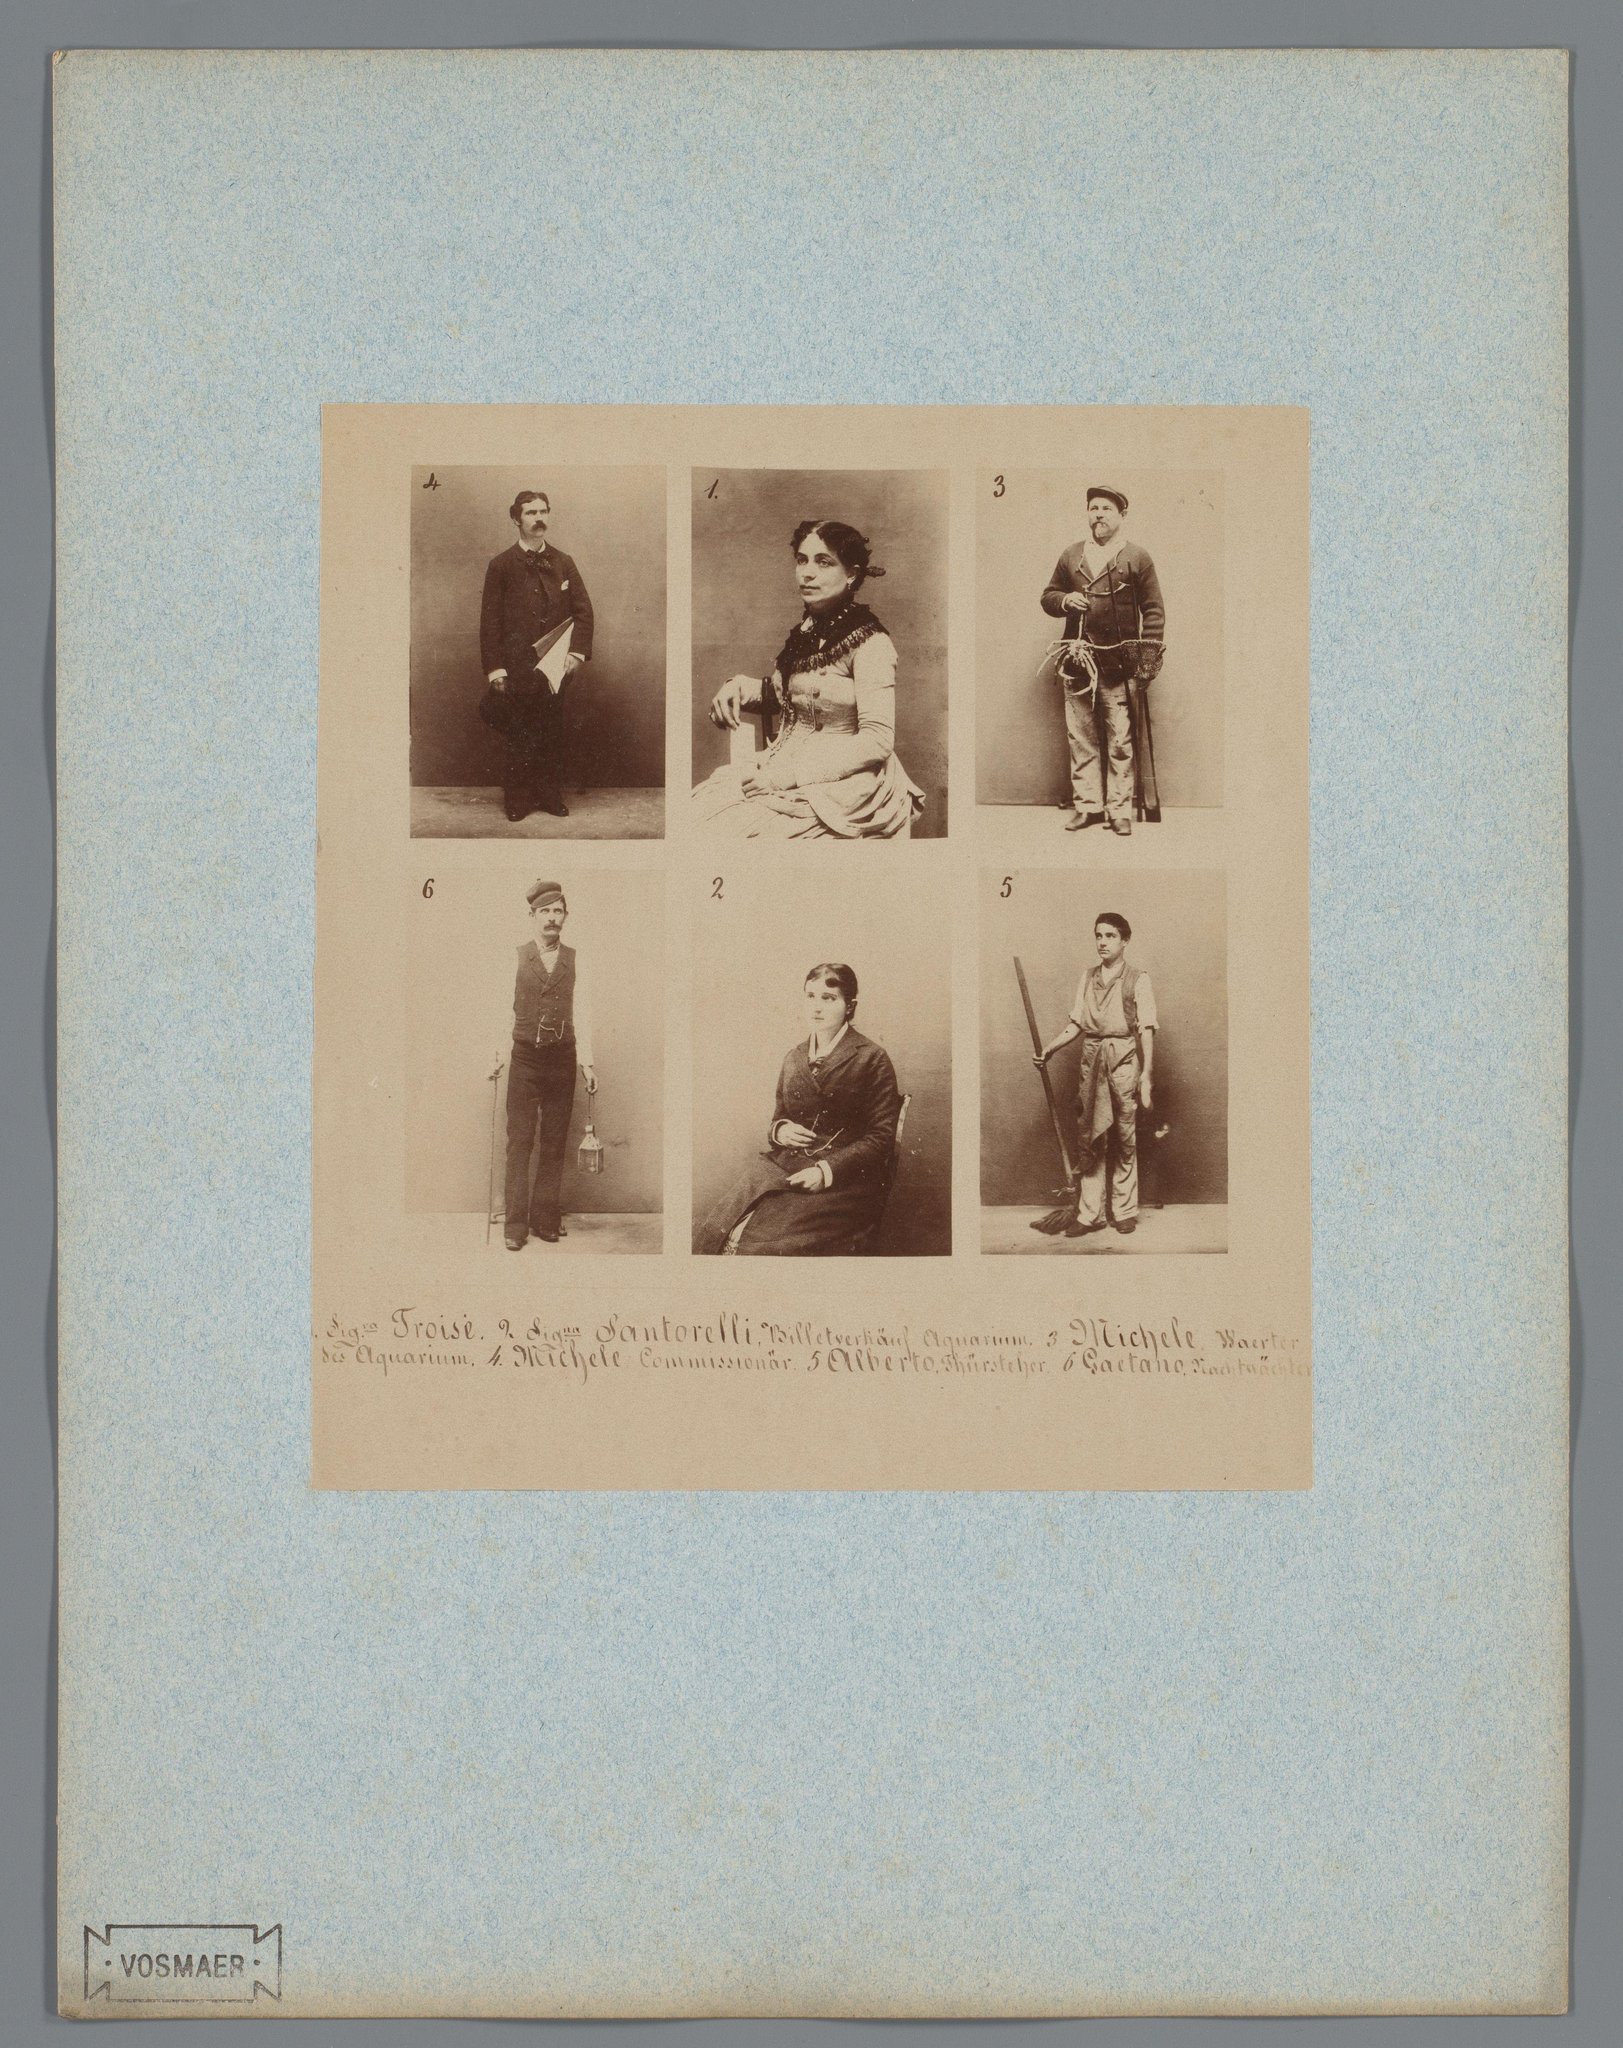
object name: photograph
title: Zes portretten van werknemers van het Zoöligisch Station te Napels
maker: Anonymous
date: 1873-1900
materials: cardboard, paper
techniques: albumen print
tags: employer ~ employee, historical persons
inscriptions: collector's mark: ‘VOSMAER’, number